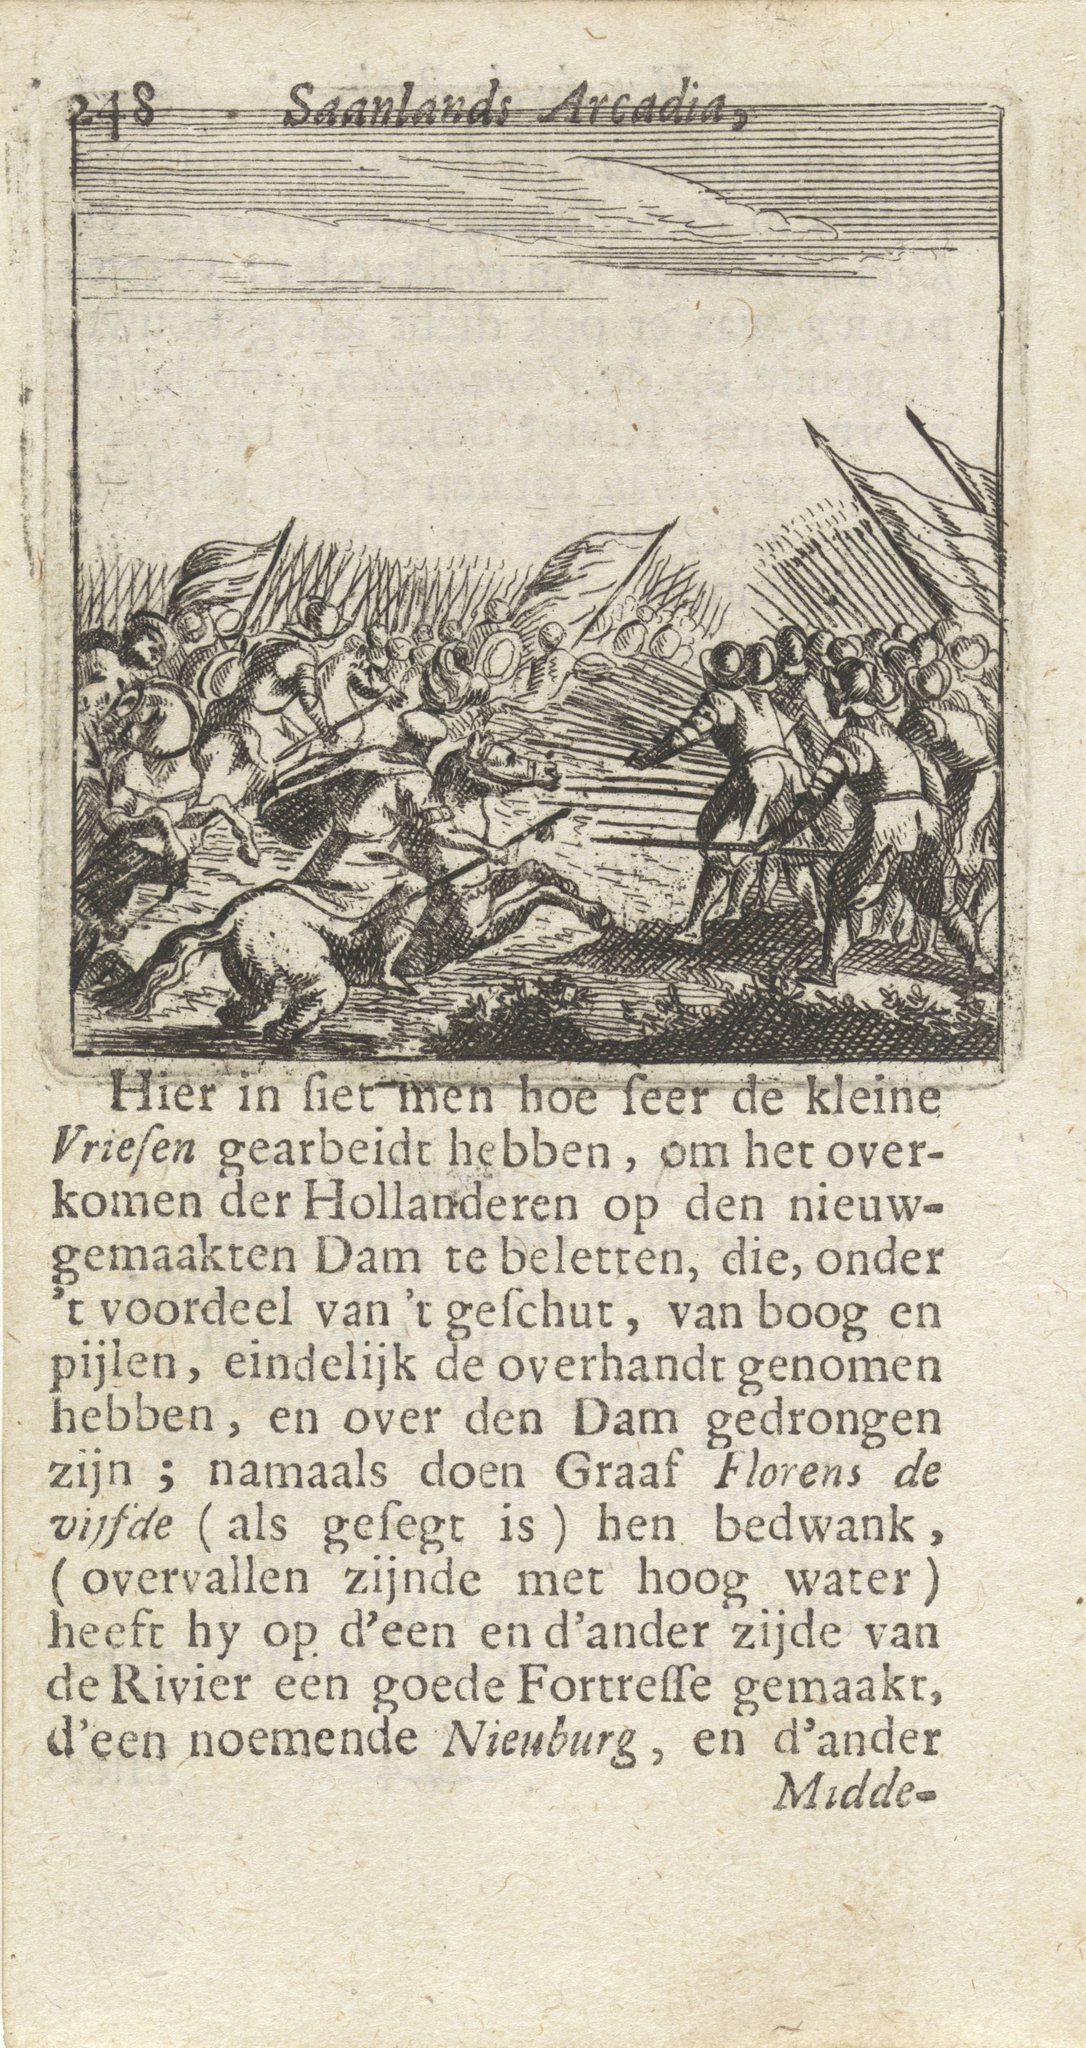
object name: book illustration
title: Strijd van de West-Friezen tegen de Hollanders onder leiding van Floris V, graaf van Holland, 1272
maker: hendrik jacobsz soeteboom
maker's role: print maker, publisher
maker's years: 1616-1678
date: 1658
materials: paper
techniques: engraving, etching, letterpress printing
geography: zaandam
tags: battle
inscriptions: collector's mark: Lugt 2760, collector's mark: Lugt 2228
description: Slagveld met ruiters en voetvolk. De prent stelt de strijd voortussen de West-Friezen en de grafelijke legers bij de door de Hollanders aangelegde uitvalsdijk tussen de zandrug van Alkmaar en de hoge geestgronden van Oudorp en Vronen. Boven en onder de prent tekst in boekdruk.